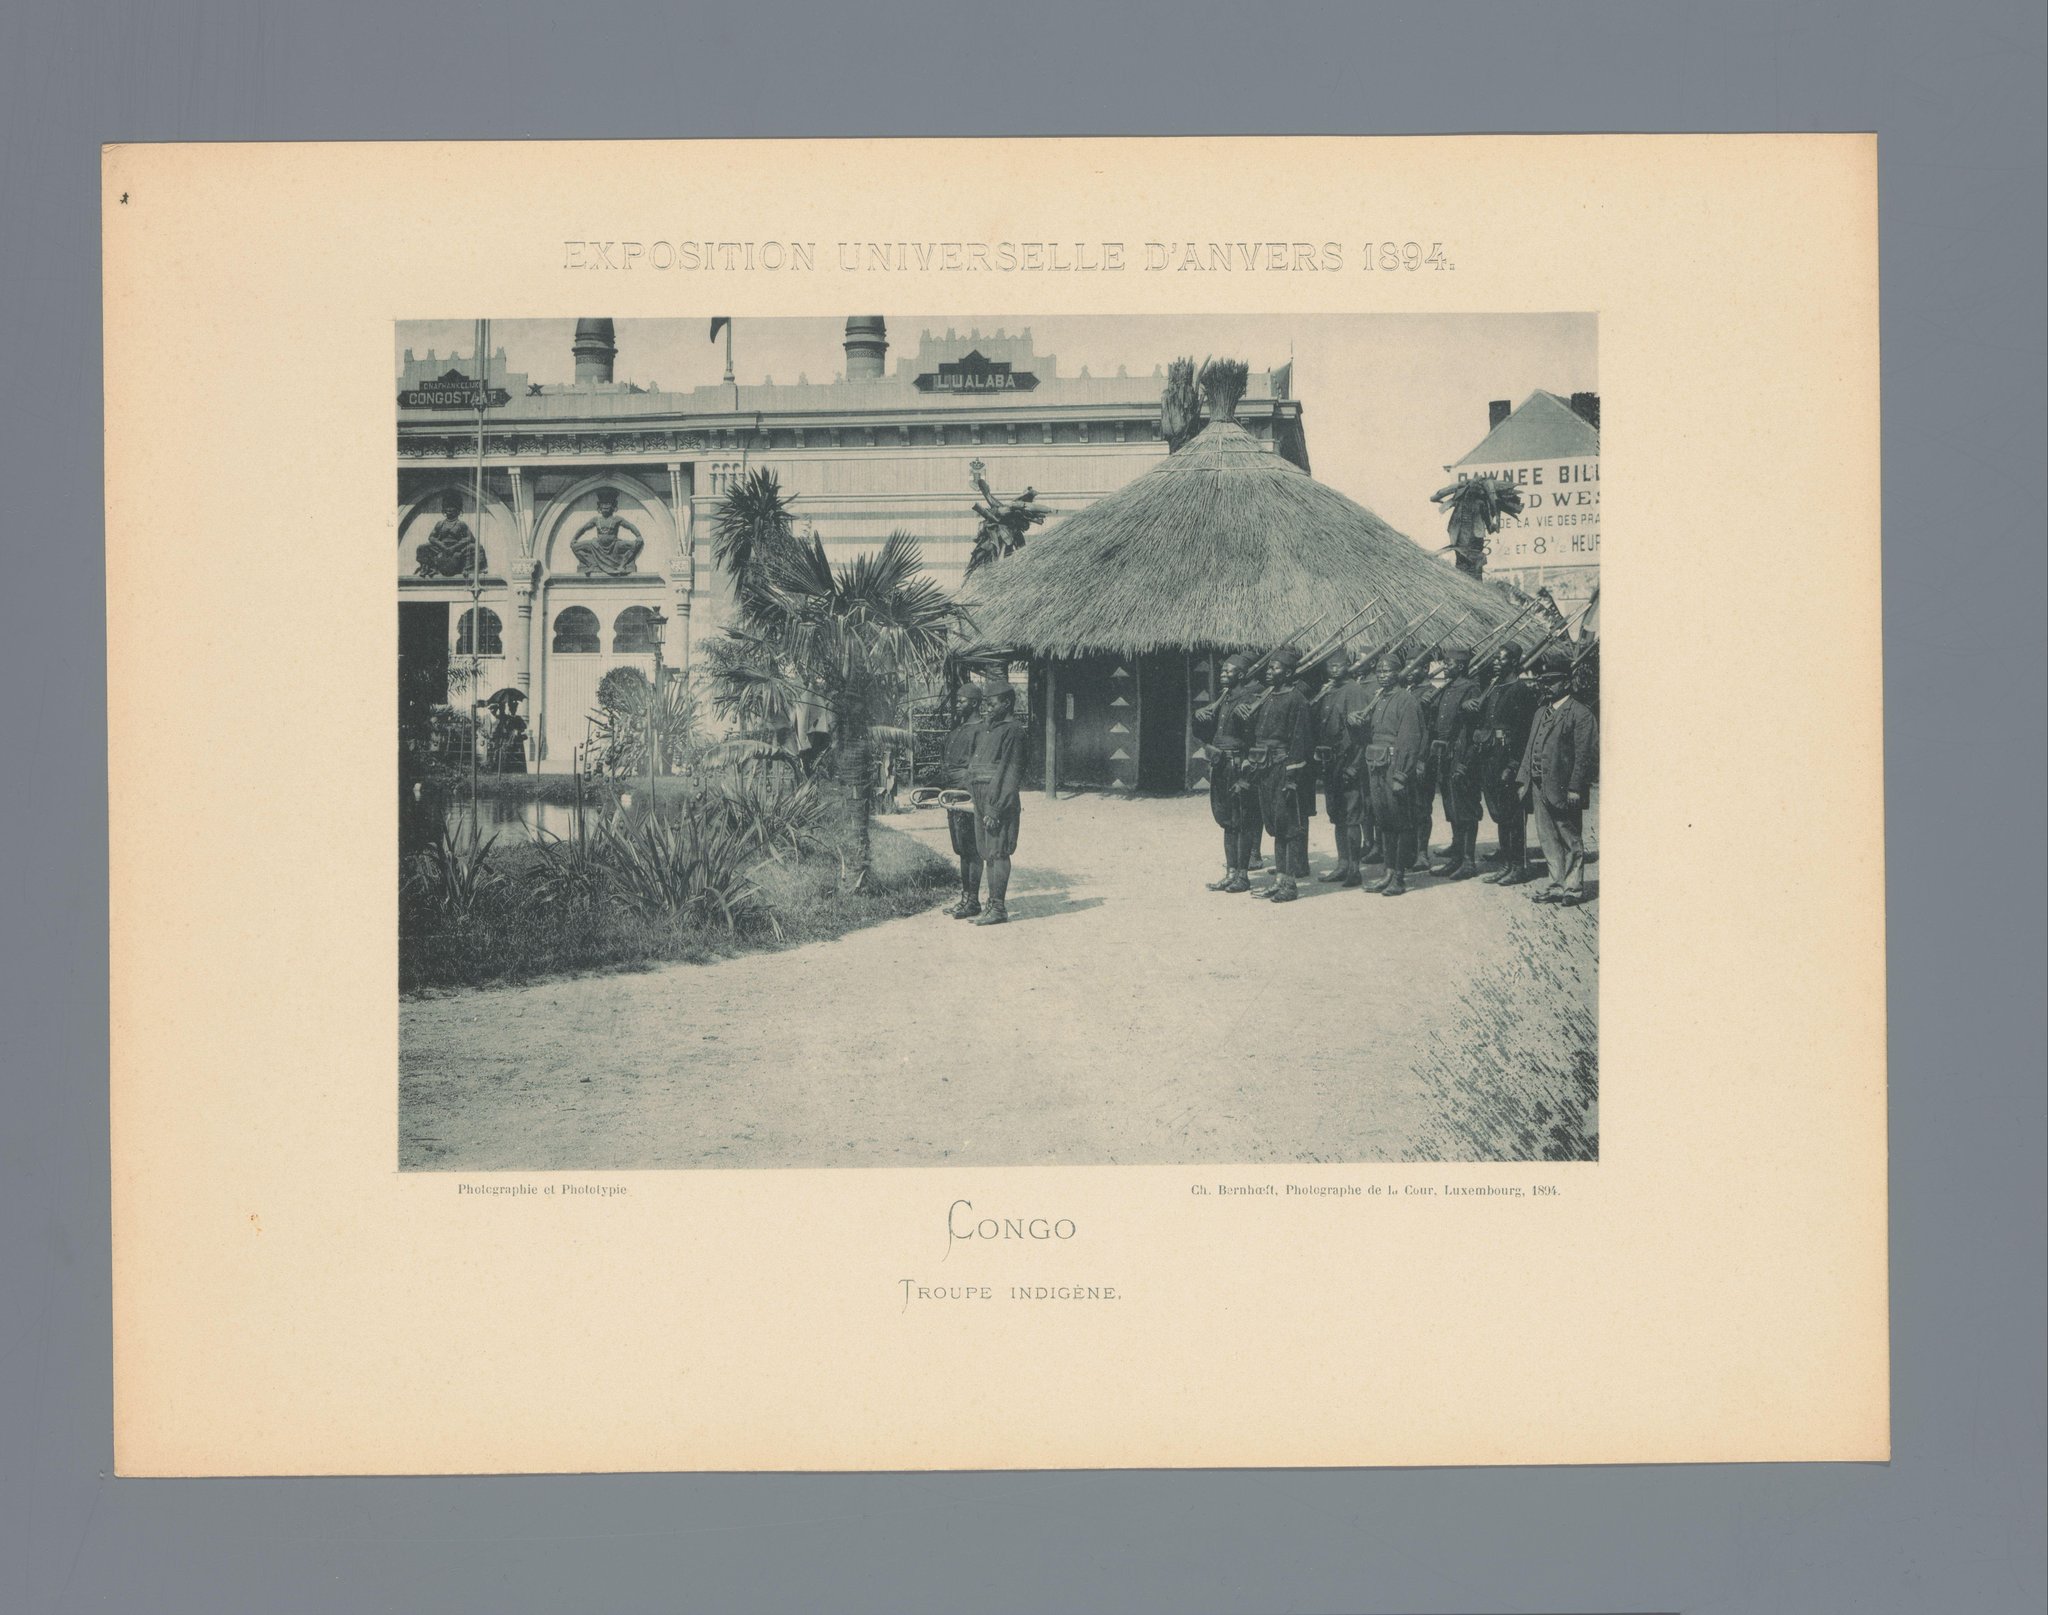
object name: photomechanical print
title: Congo Troupe indigène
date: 1894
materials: paper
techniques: photograph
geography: antwerp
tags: world fair, world exhibition, adult man, (military) uniforms, antwerp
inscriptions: inscription: ‘Exposition universelle D'Anvers 1894.’